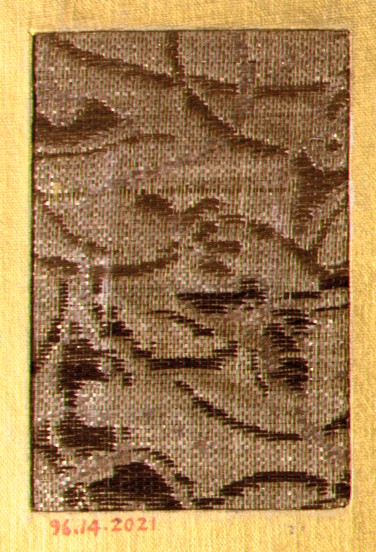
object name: piece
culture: japanese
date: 1701-1900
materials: silk